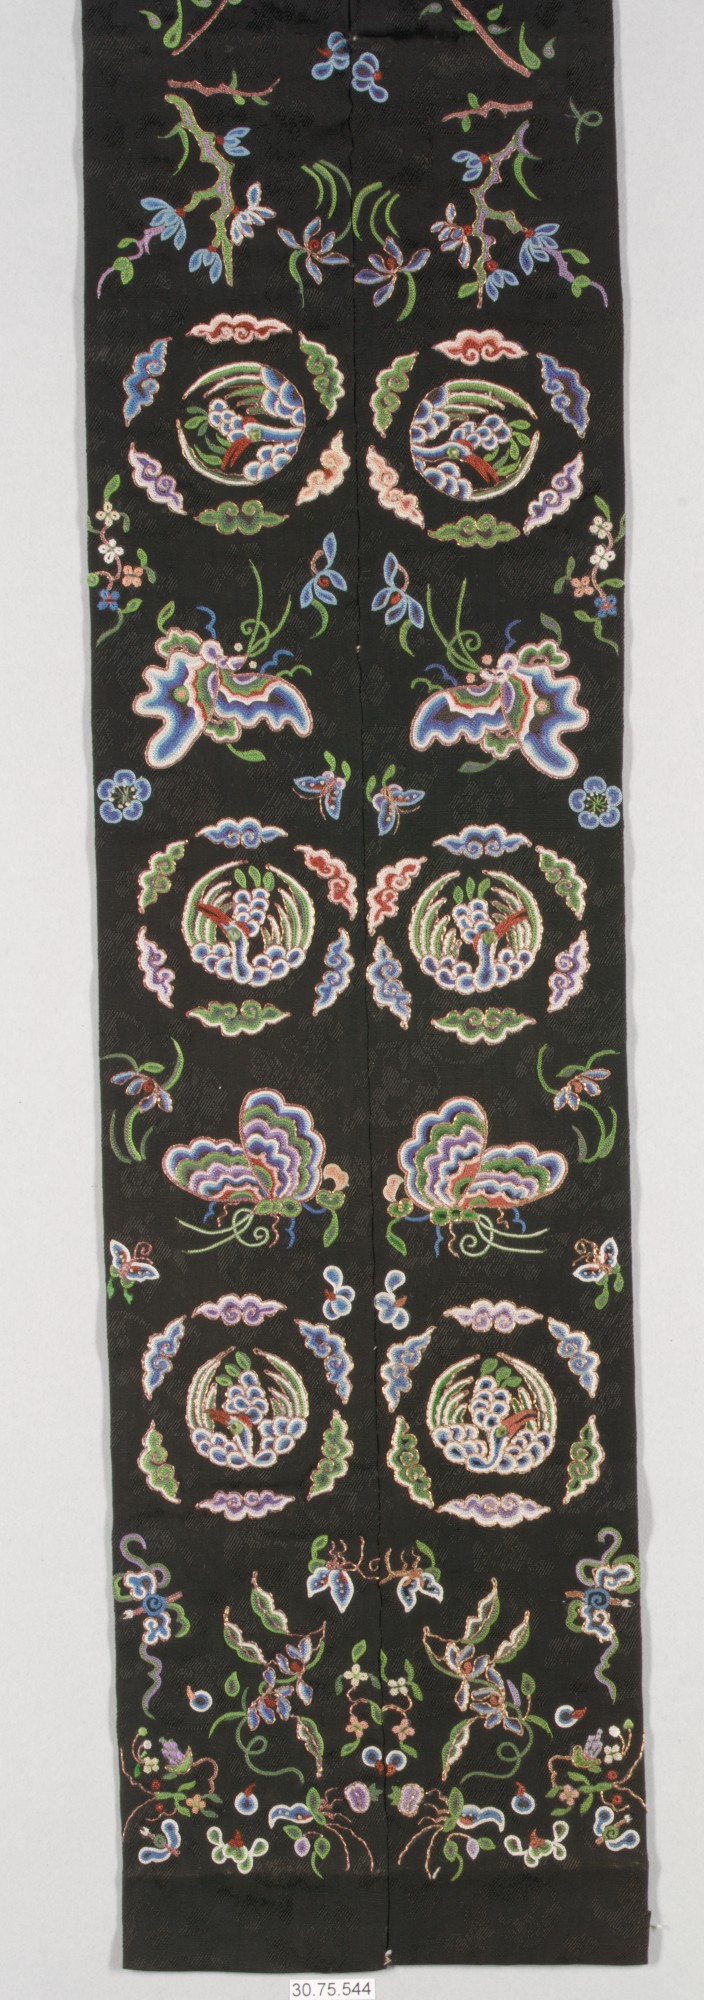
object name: sleeve band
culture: chinese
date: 1801-1900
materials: silk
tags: butterflies,flowers